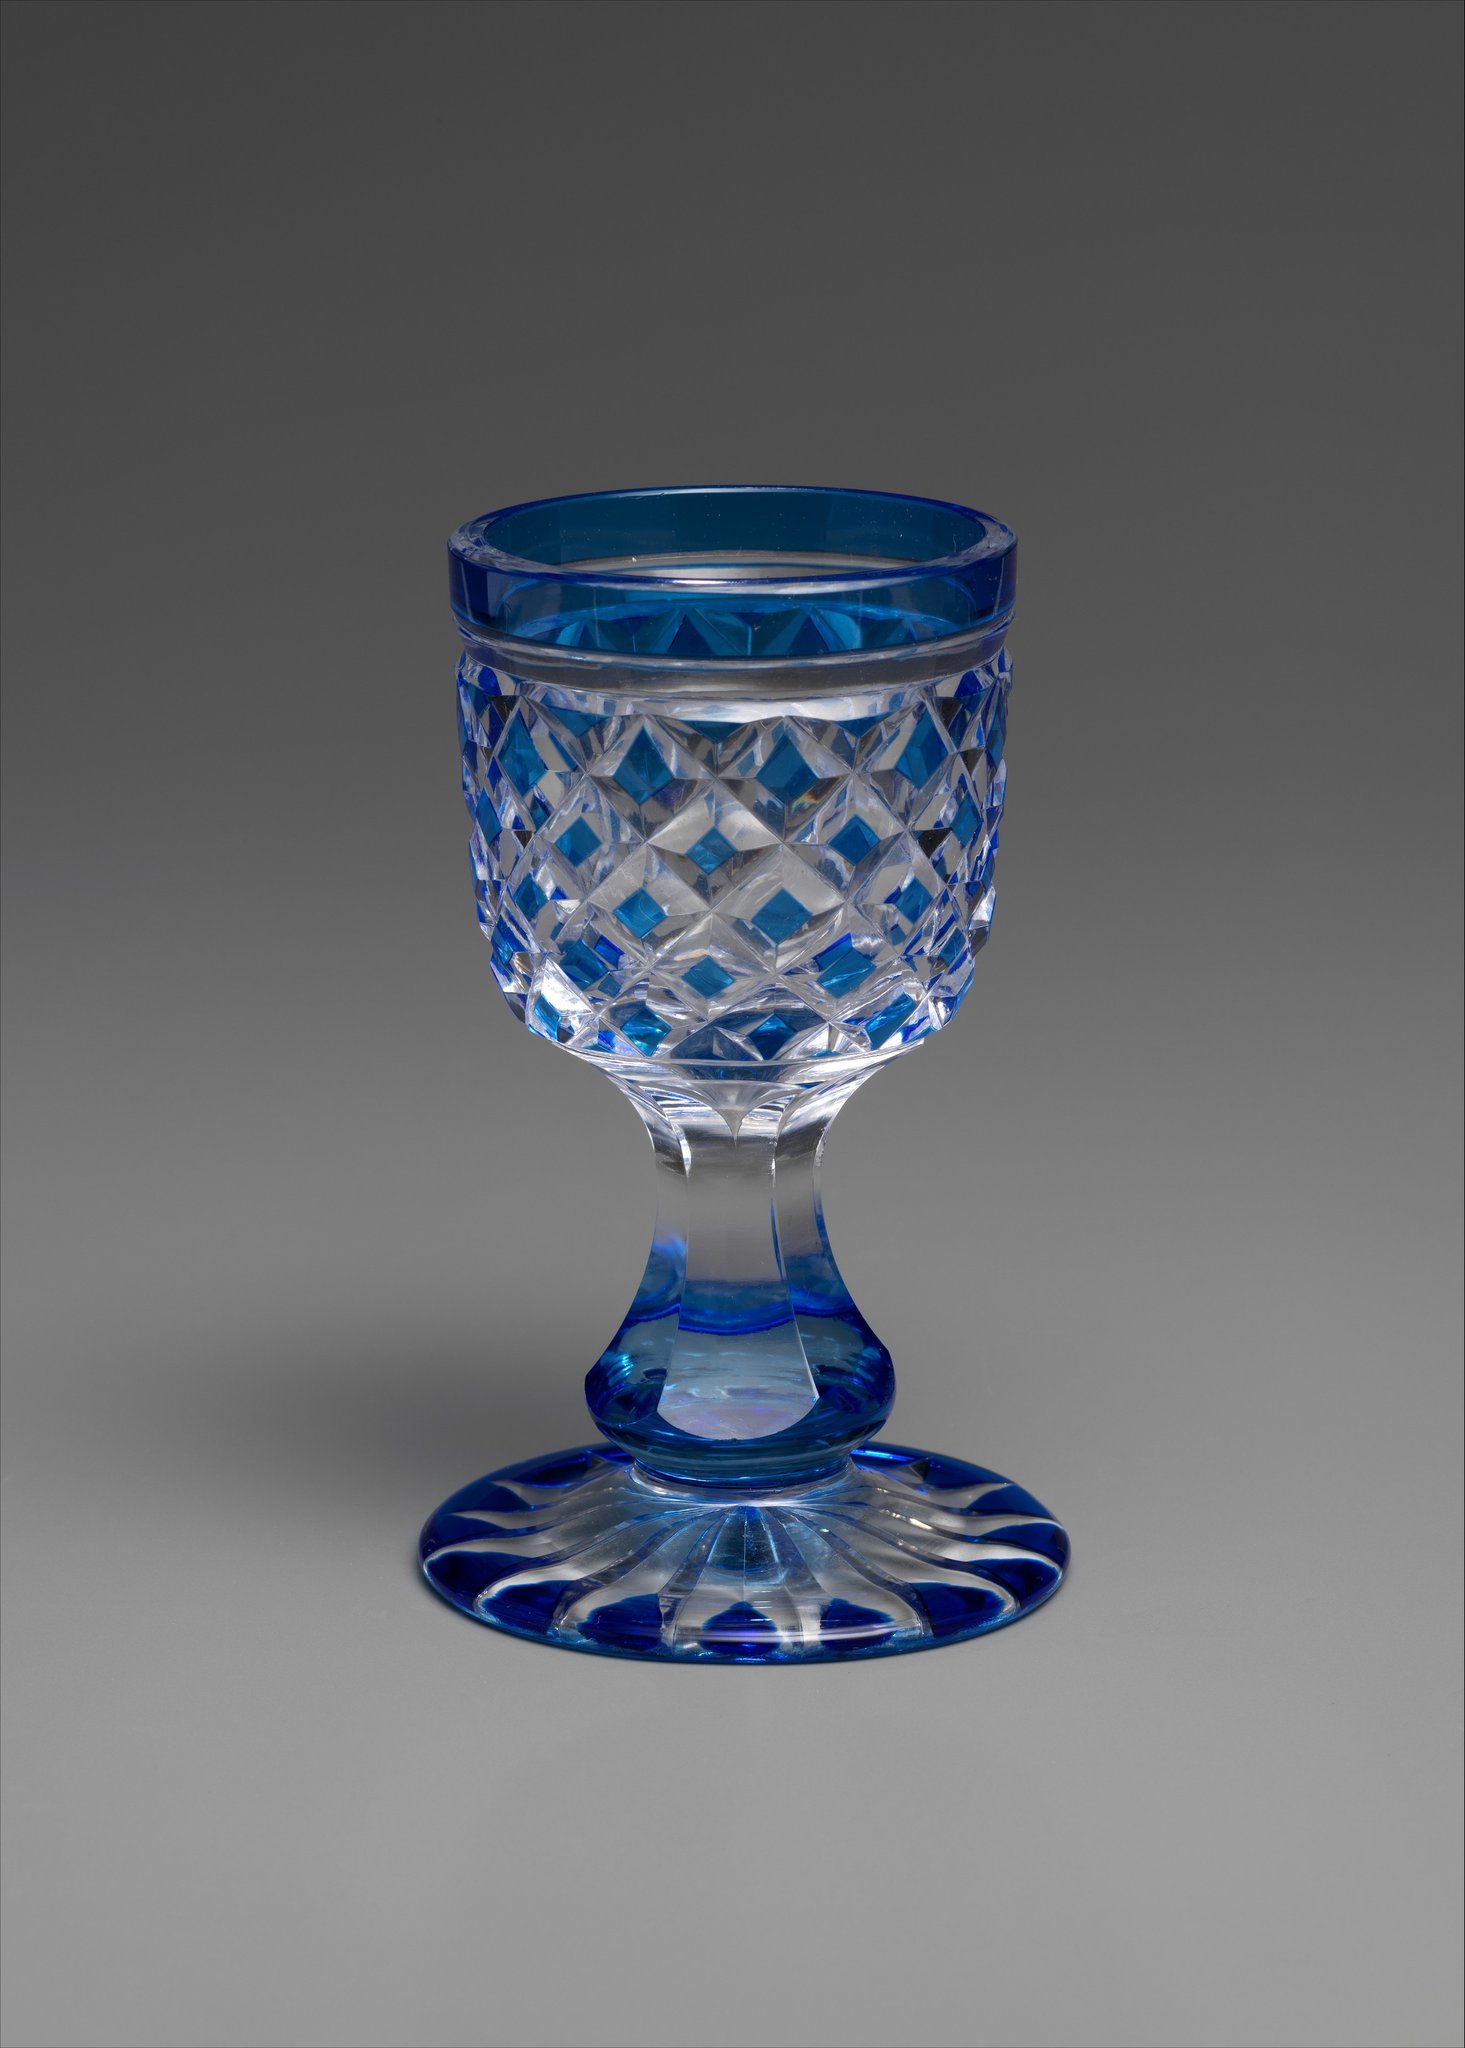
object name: cordial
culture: american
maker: brooklyn flint glass company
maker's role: manufacturer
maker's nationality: american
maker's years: 1824-1868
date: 1850-1855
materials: glass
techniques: cutting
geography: united states